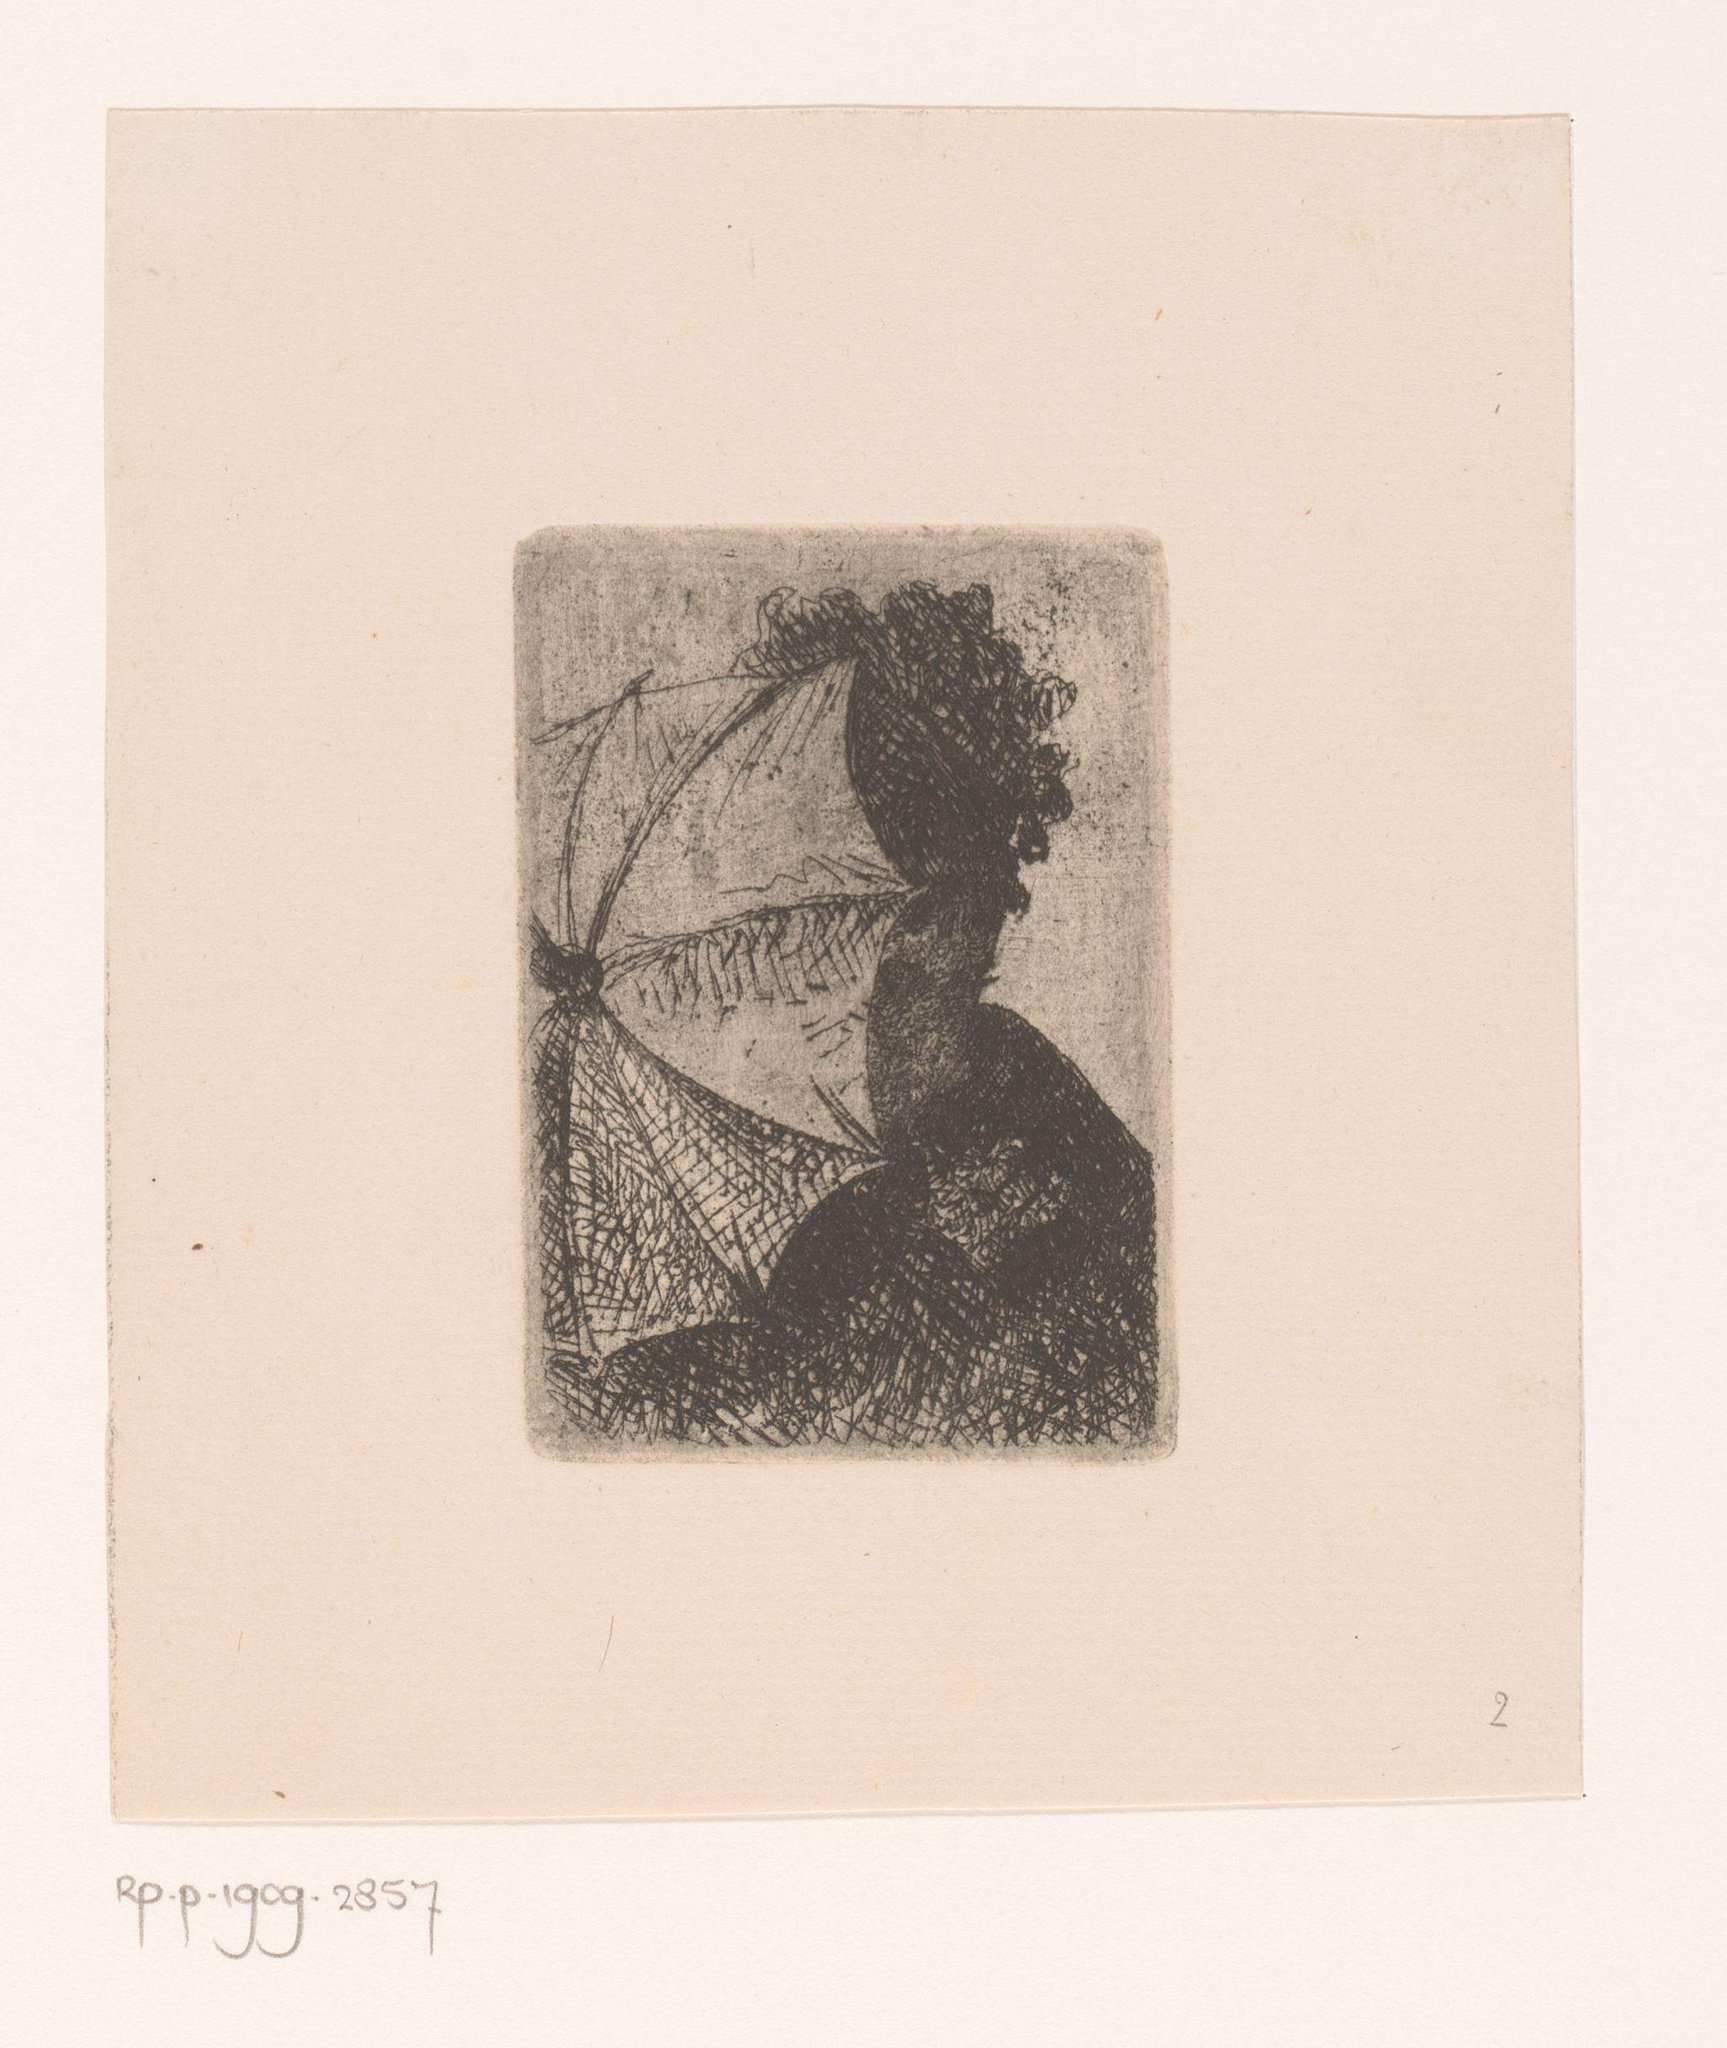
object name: print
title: Jonge vrouw met een parasol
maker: constant aimé marie cap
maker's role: print maker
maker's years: 1842-1915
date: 1874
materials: paper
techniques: drypoint, etching, intaglio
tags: parasol, sunshade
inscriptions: collector's mark: Lugt 2228